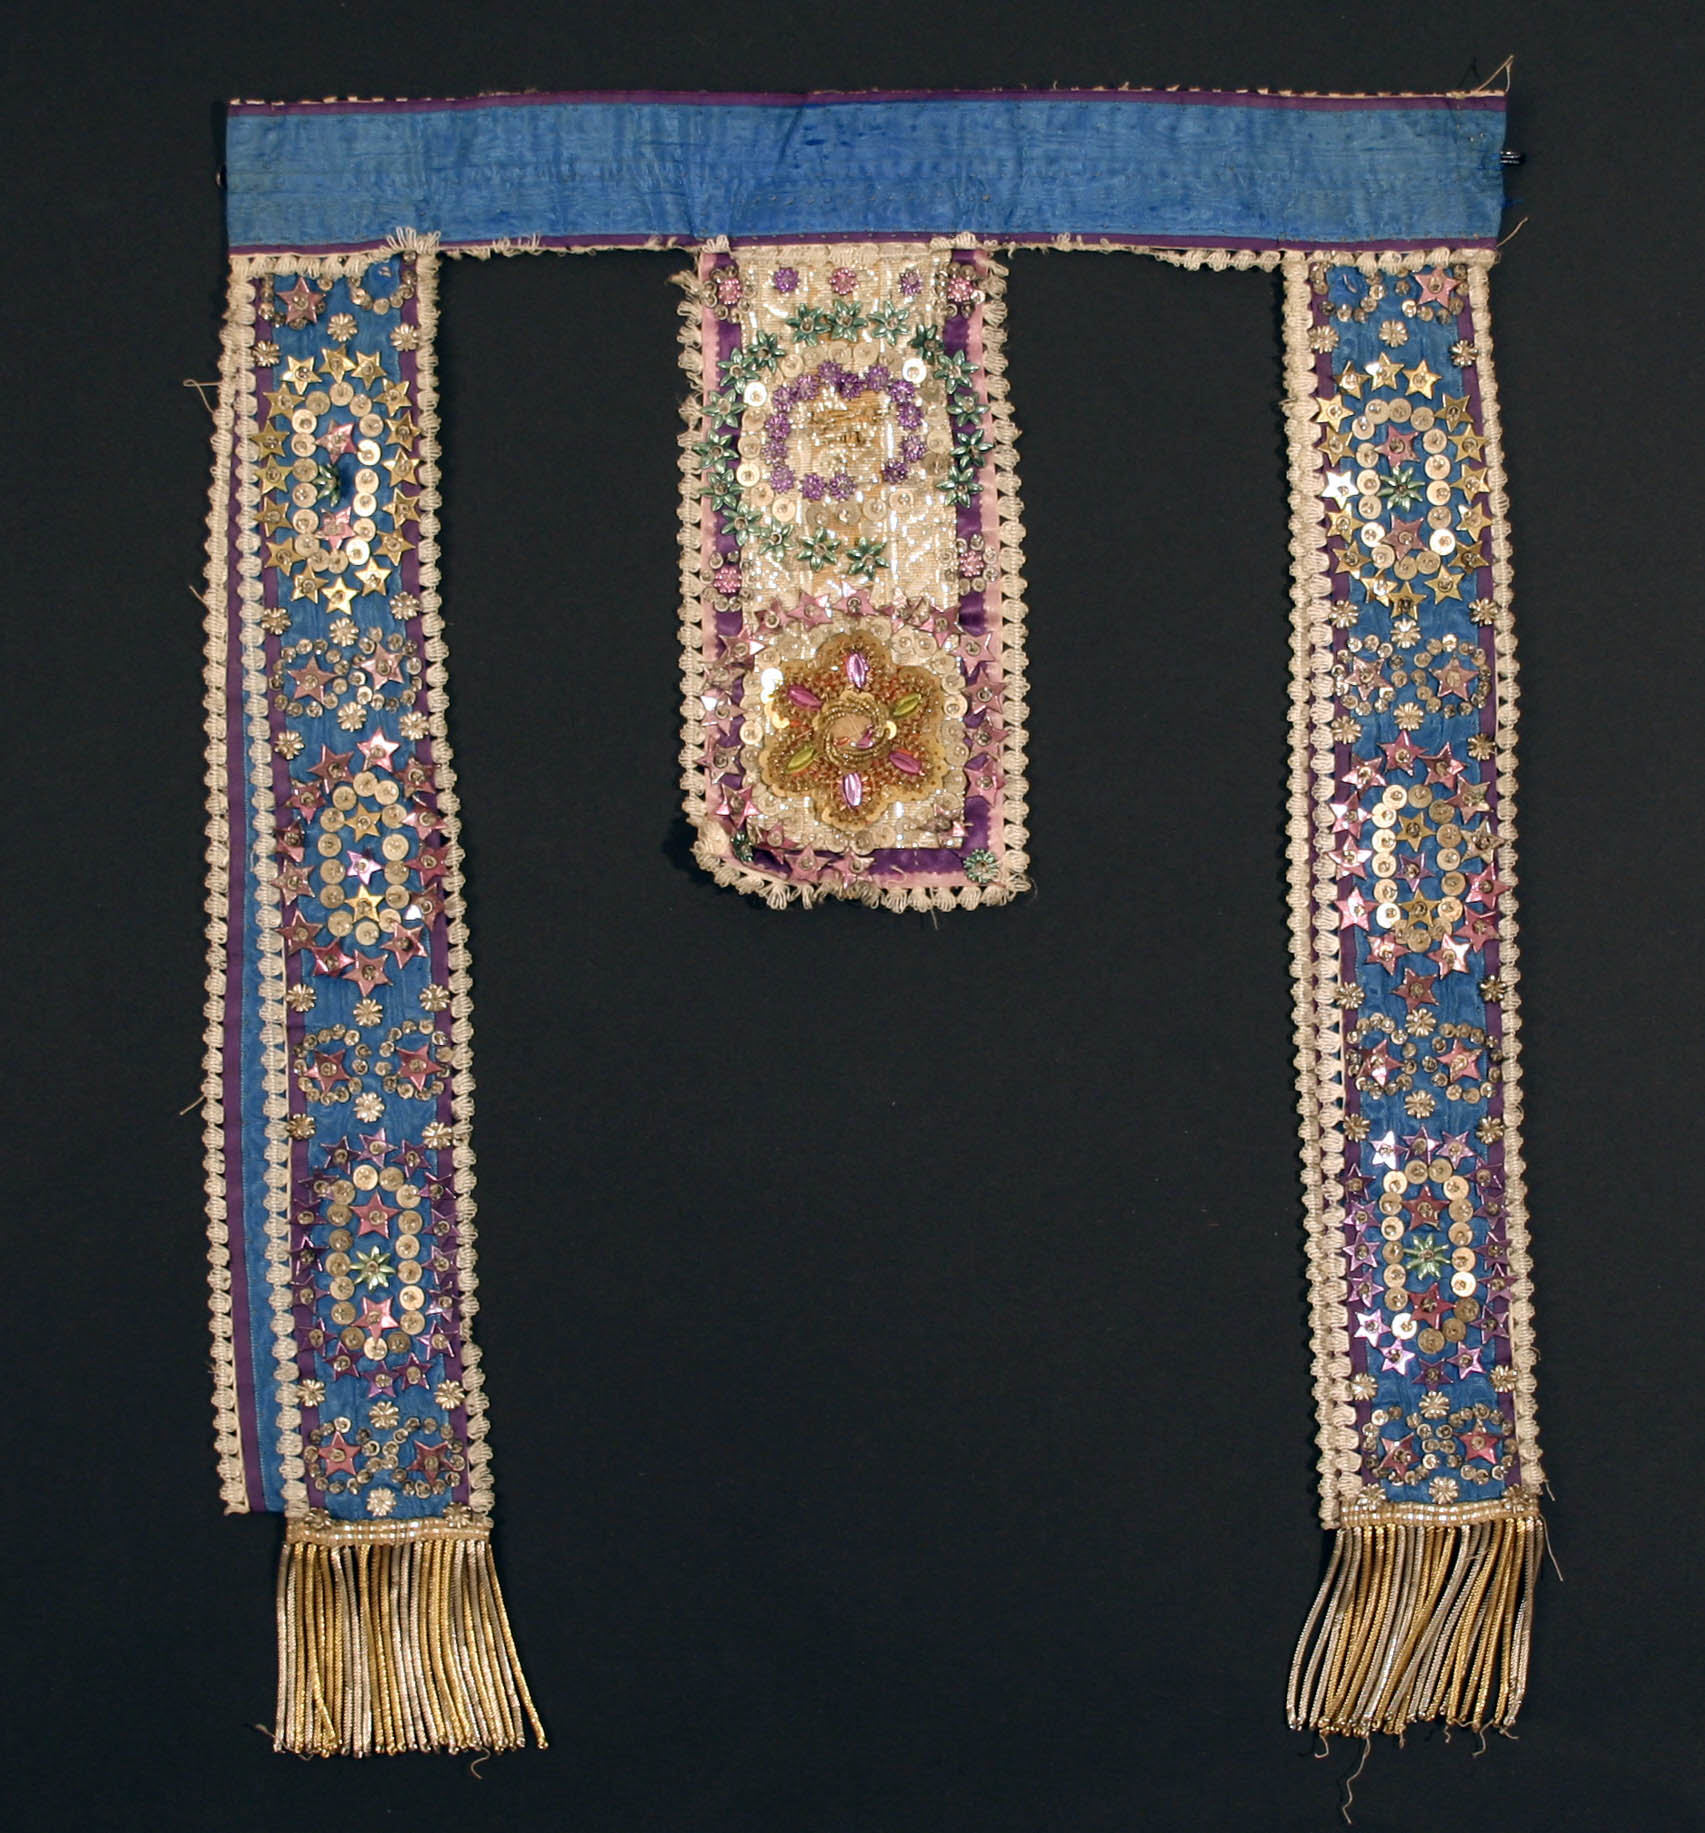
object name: ribbon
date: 1801-1900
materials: metal, silk